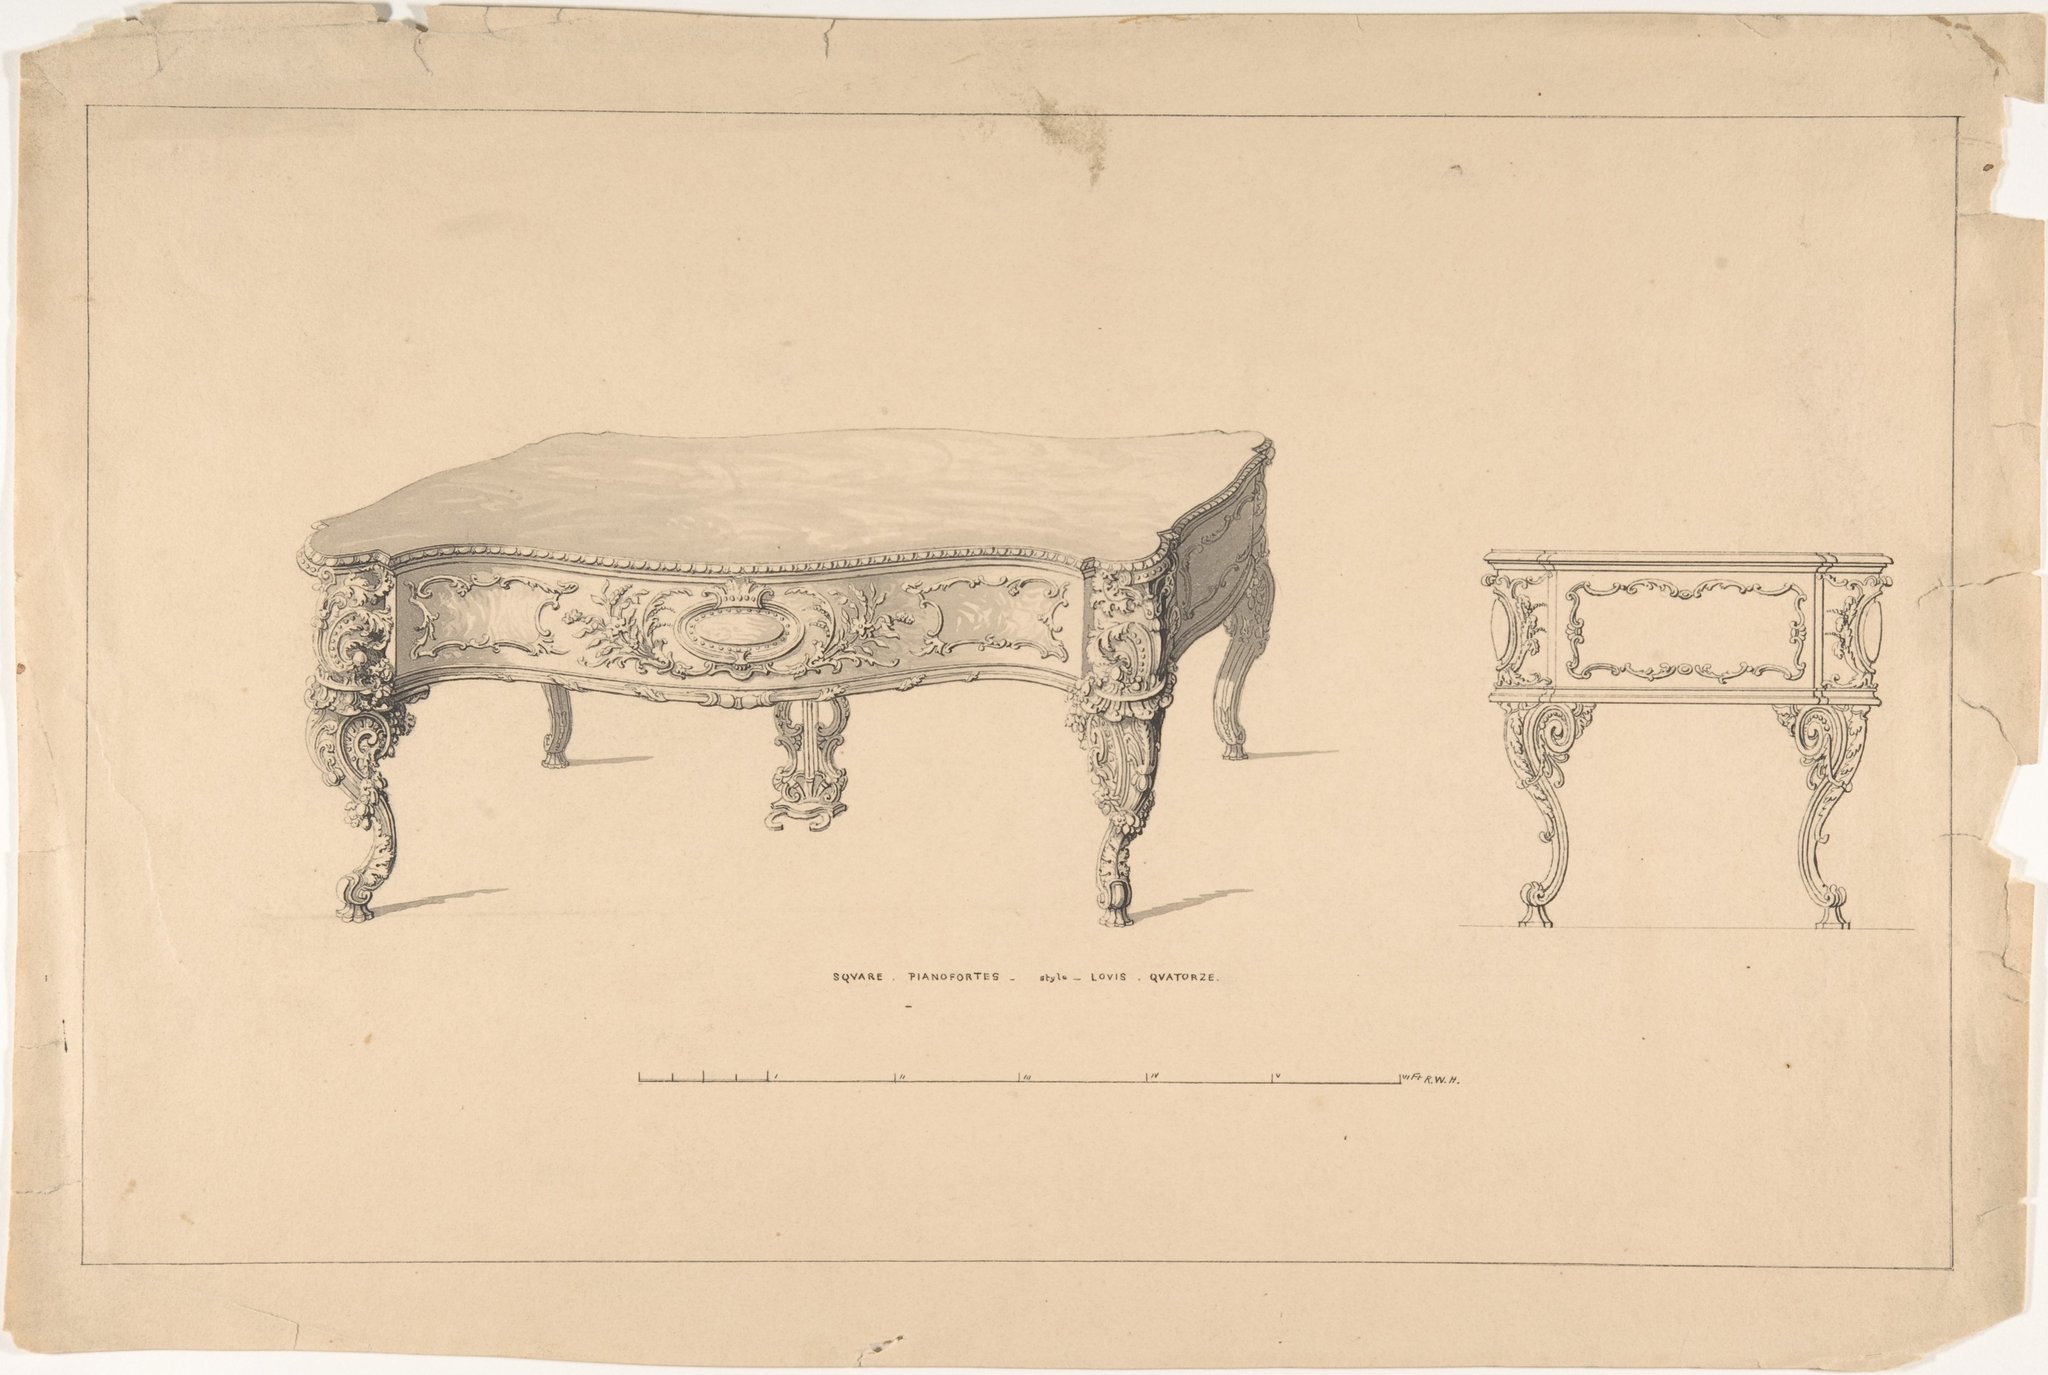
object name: drawing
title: Design for Square Pianoforte, Louis Quatorze Style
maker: robert william hume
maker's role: artist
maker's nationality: british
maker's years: 1816-1904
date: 1835-1900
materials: graphite, ink, watercolor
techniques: pen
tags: musical instruments